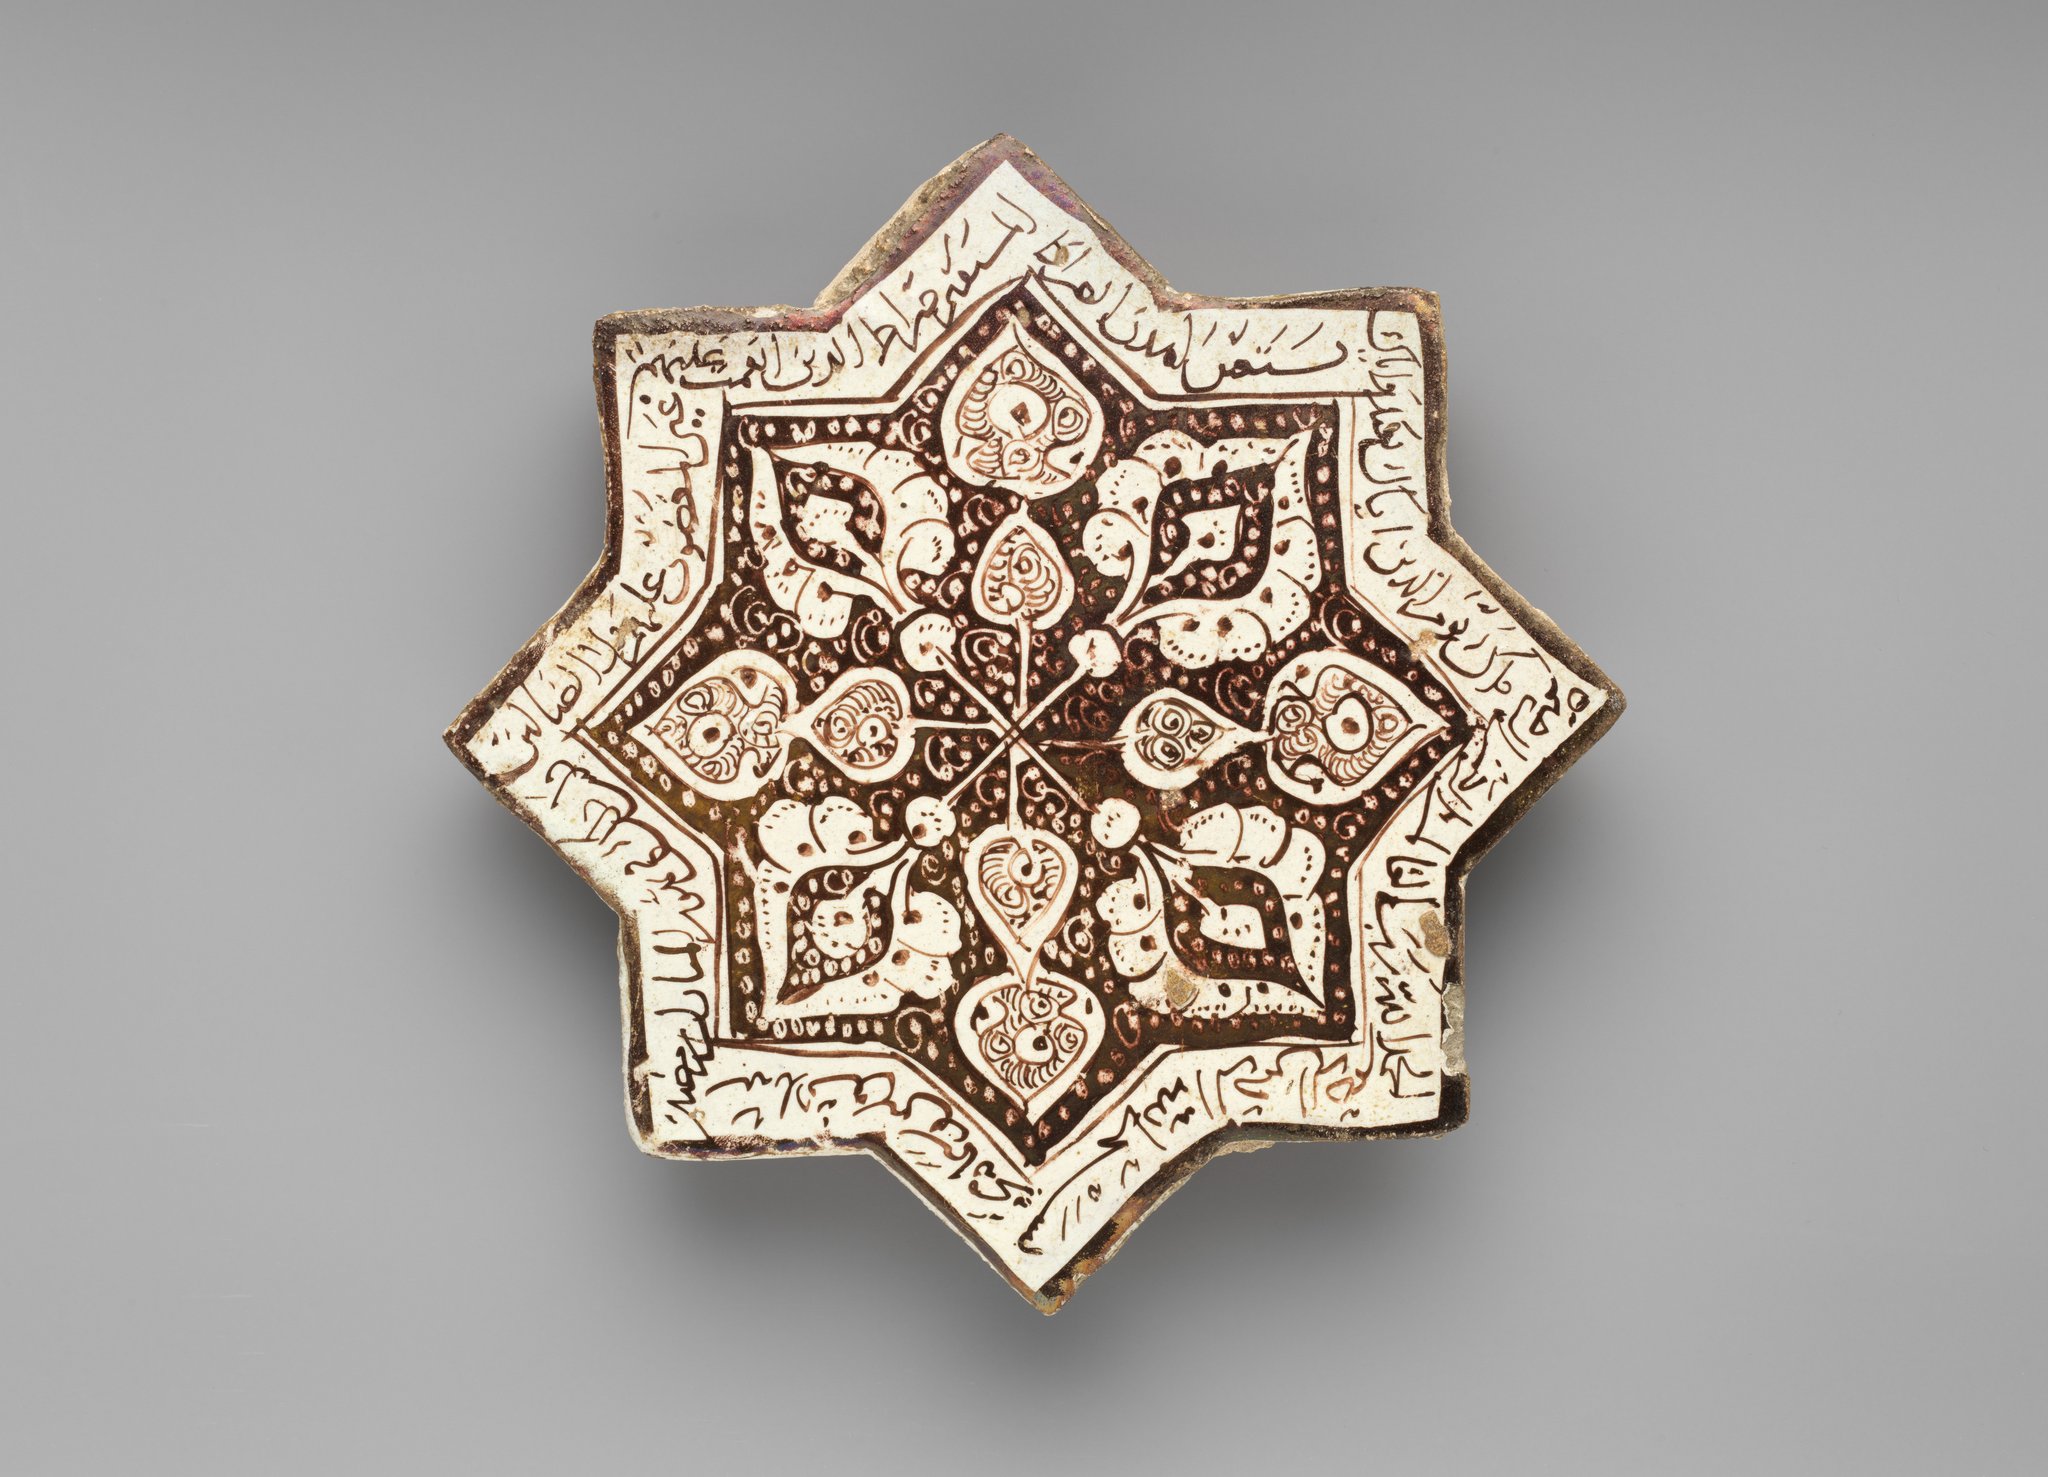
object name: tile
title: Star-Shaped Tile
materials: glaze, stonepaste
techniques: luster painting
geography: iran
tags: arabic